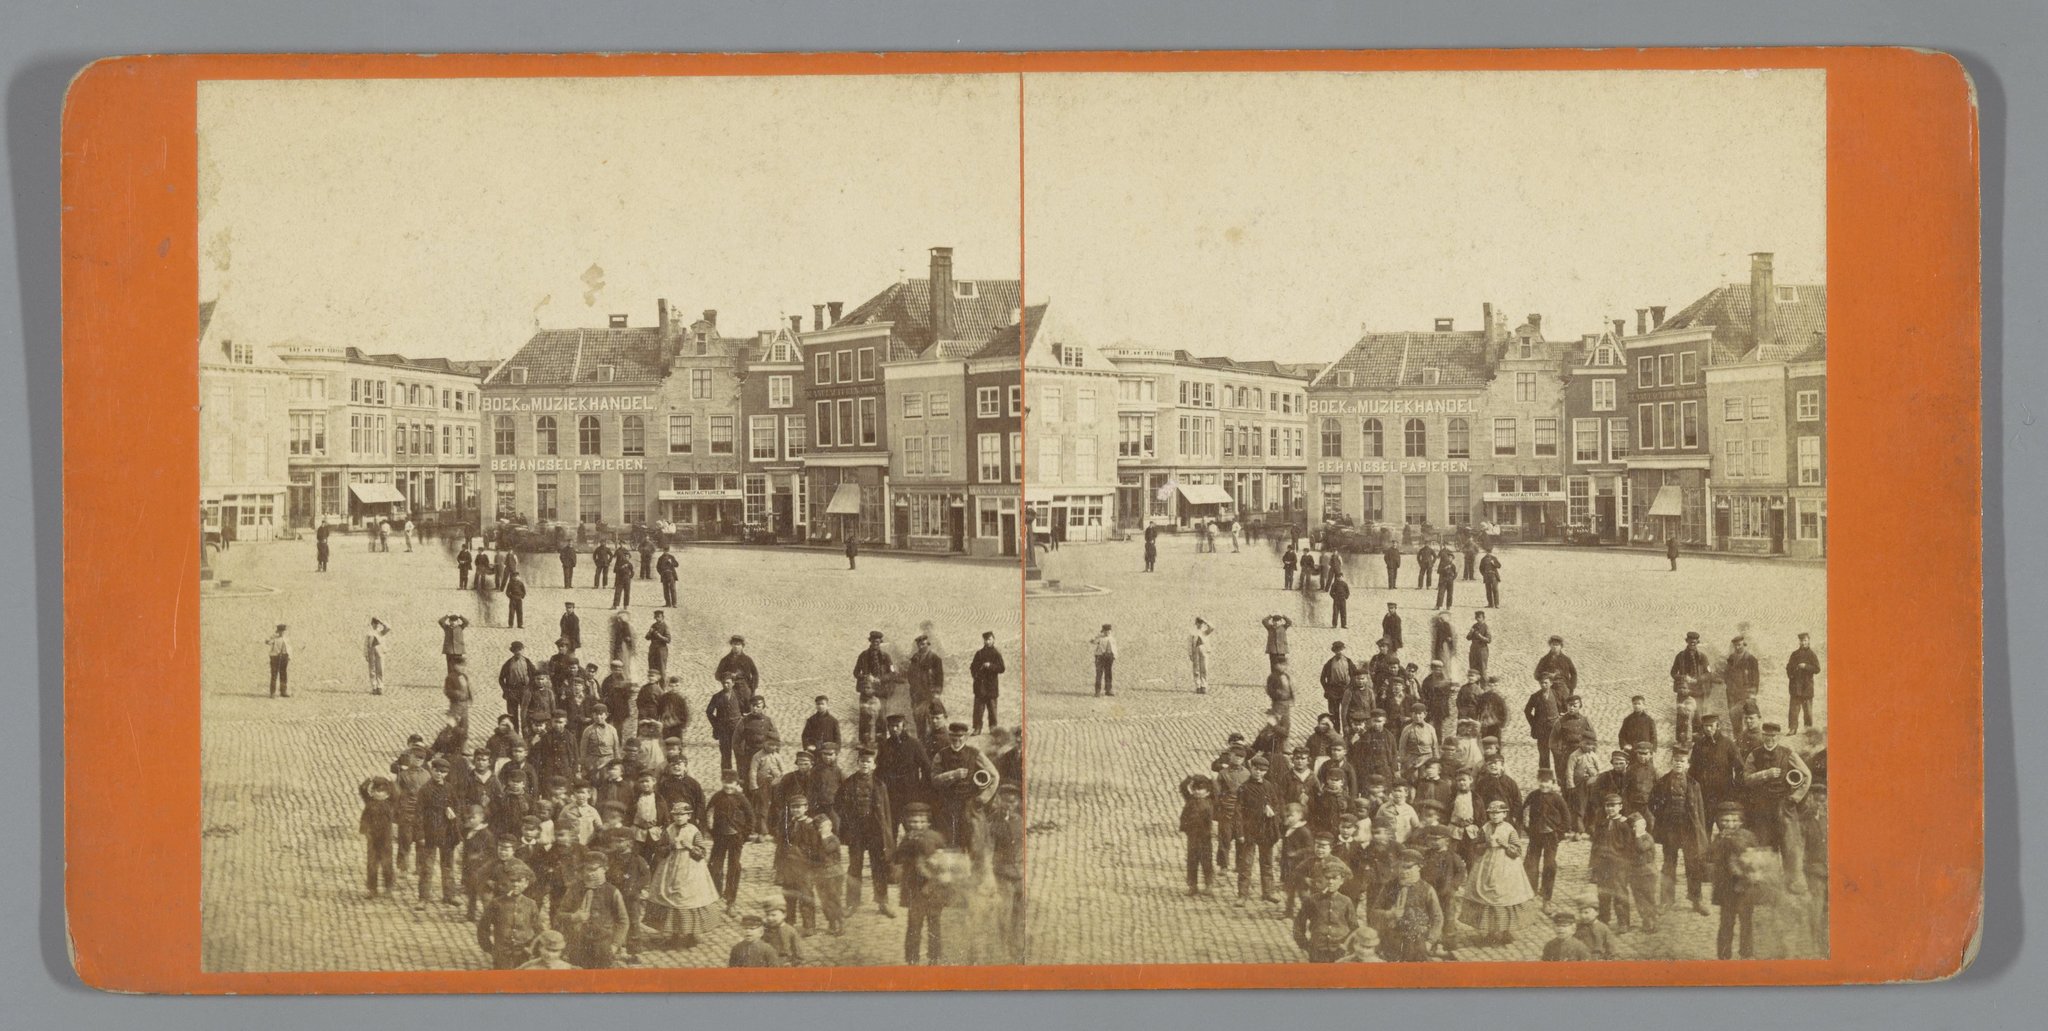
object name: stereograph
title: Mensen op een plein, Nederland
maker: Anonymous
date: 1868-1890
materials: cardboard, paper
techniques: albumen print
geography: netherlands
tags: square, place, circus, etc., netherlands